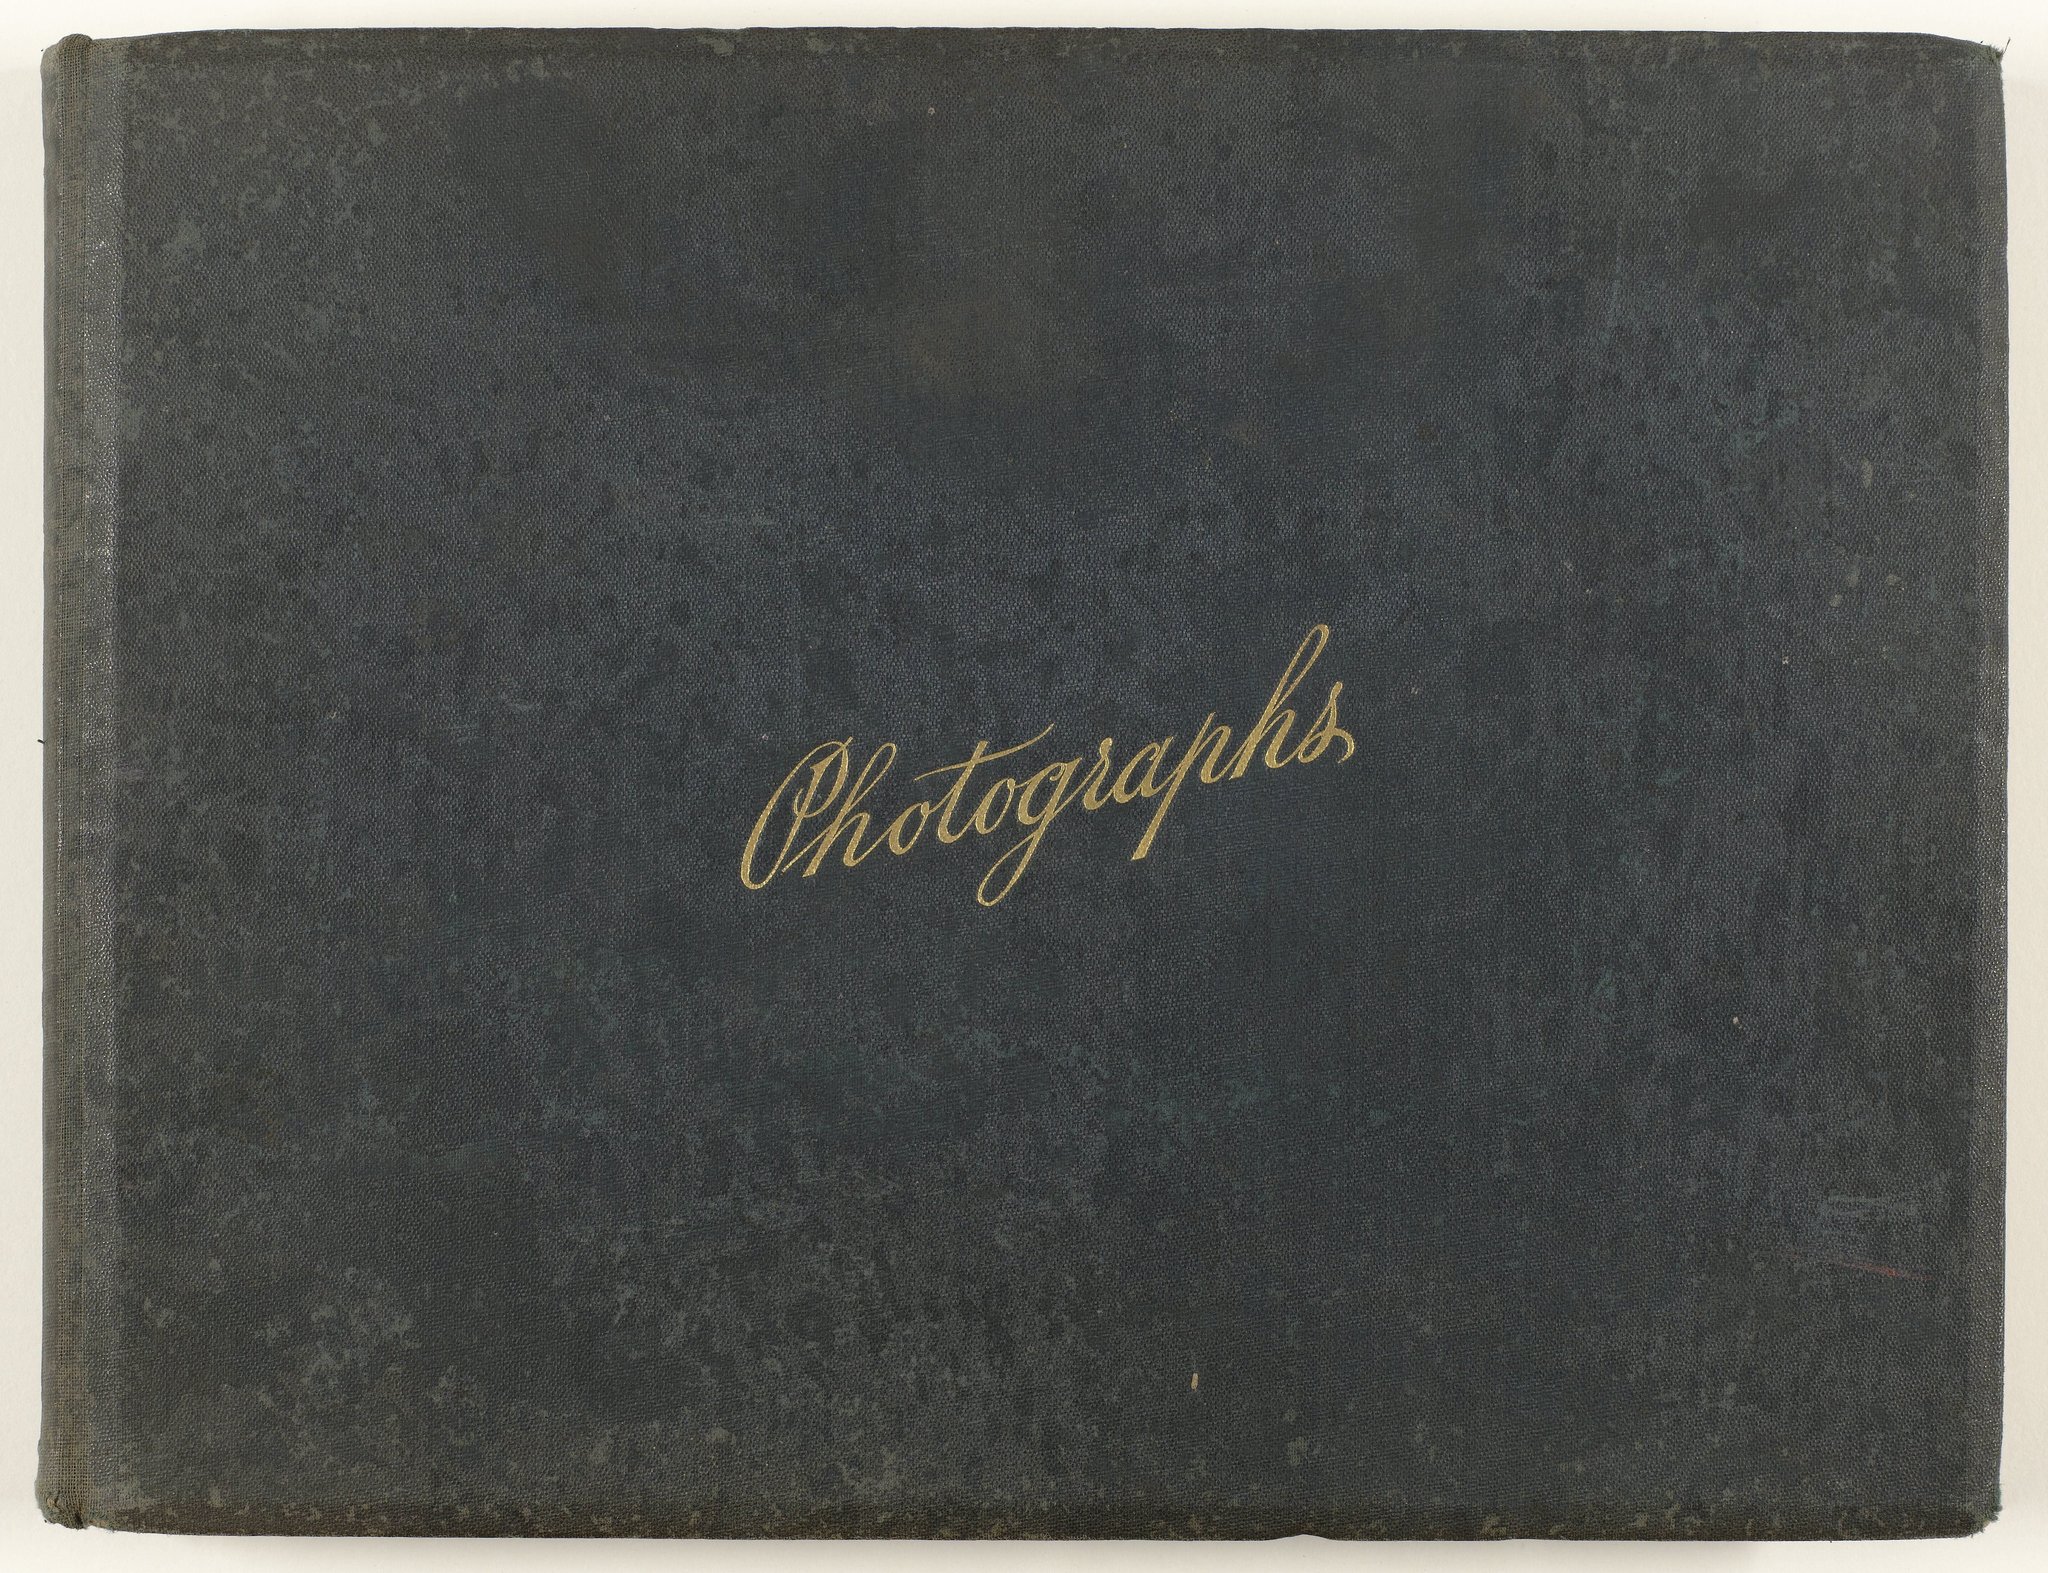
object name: scrapbook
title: Photographs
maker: Anonymous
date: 1899-1900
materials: cardboard, linen, paper, photographic support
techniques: gelatin silver print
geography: south africa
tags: warfare; military affairs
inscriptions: name: ‘D. Wentholt’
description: Fotoalbum in groenzwarte linnen band met op het voorplat de titel in gouddruk en in reliëf. De schutbladen zijn van beige papier. Op het eerste schutblad is met de hand een naam geschreven: D. Wentholt. Het album bevat 12 bladen met 23 foto's in passe-partouts en 1 los aangetroffen afdruk. Het zijn opnames gemaakt tijdens de Tweede Boerenoorlog (1899-1902), voornamelijk in de jaren 1899/1900, van vluchtelingen, manschappen, krijgsgevangenen, slachtoffers, materieel en verwoestingen.